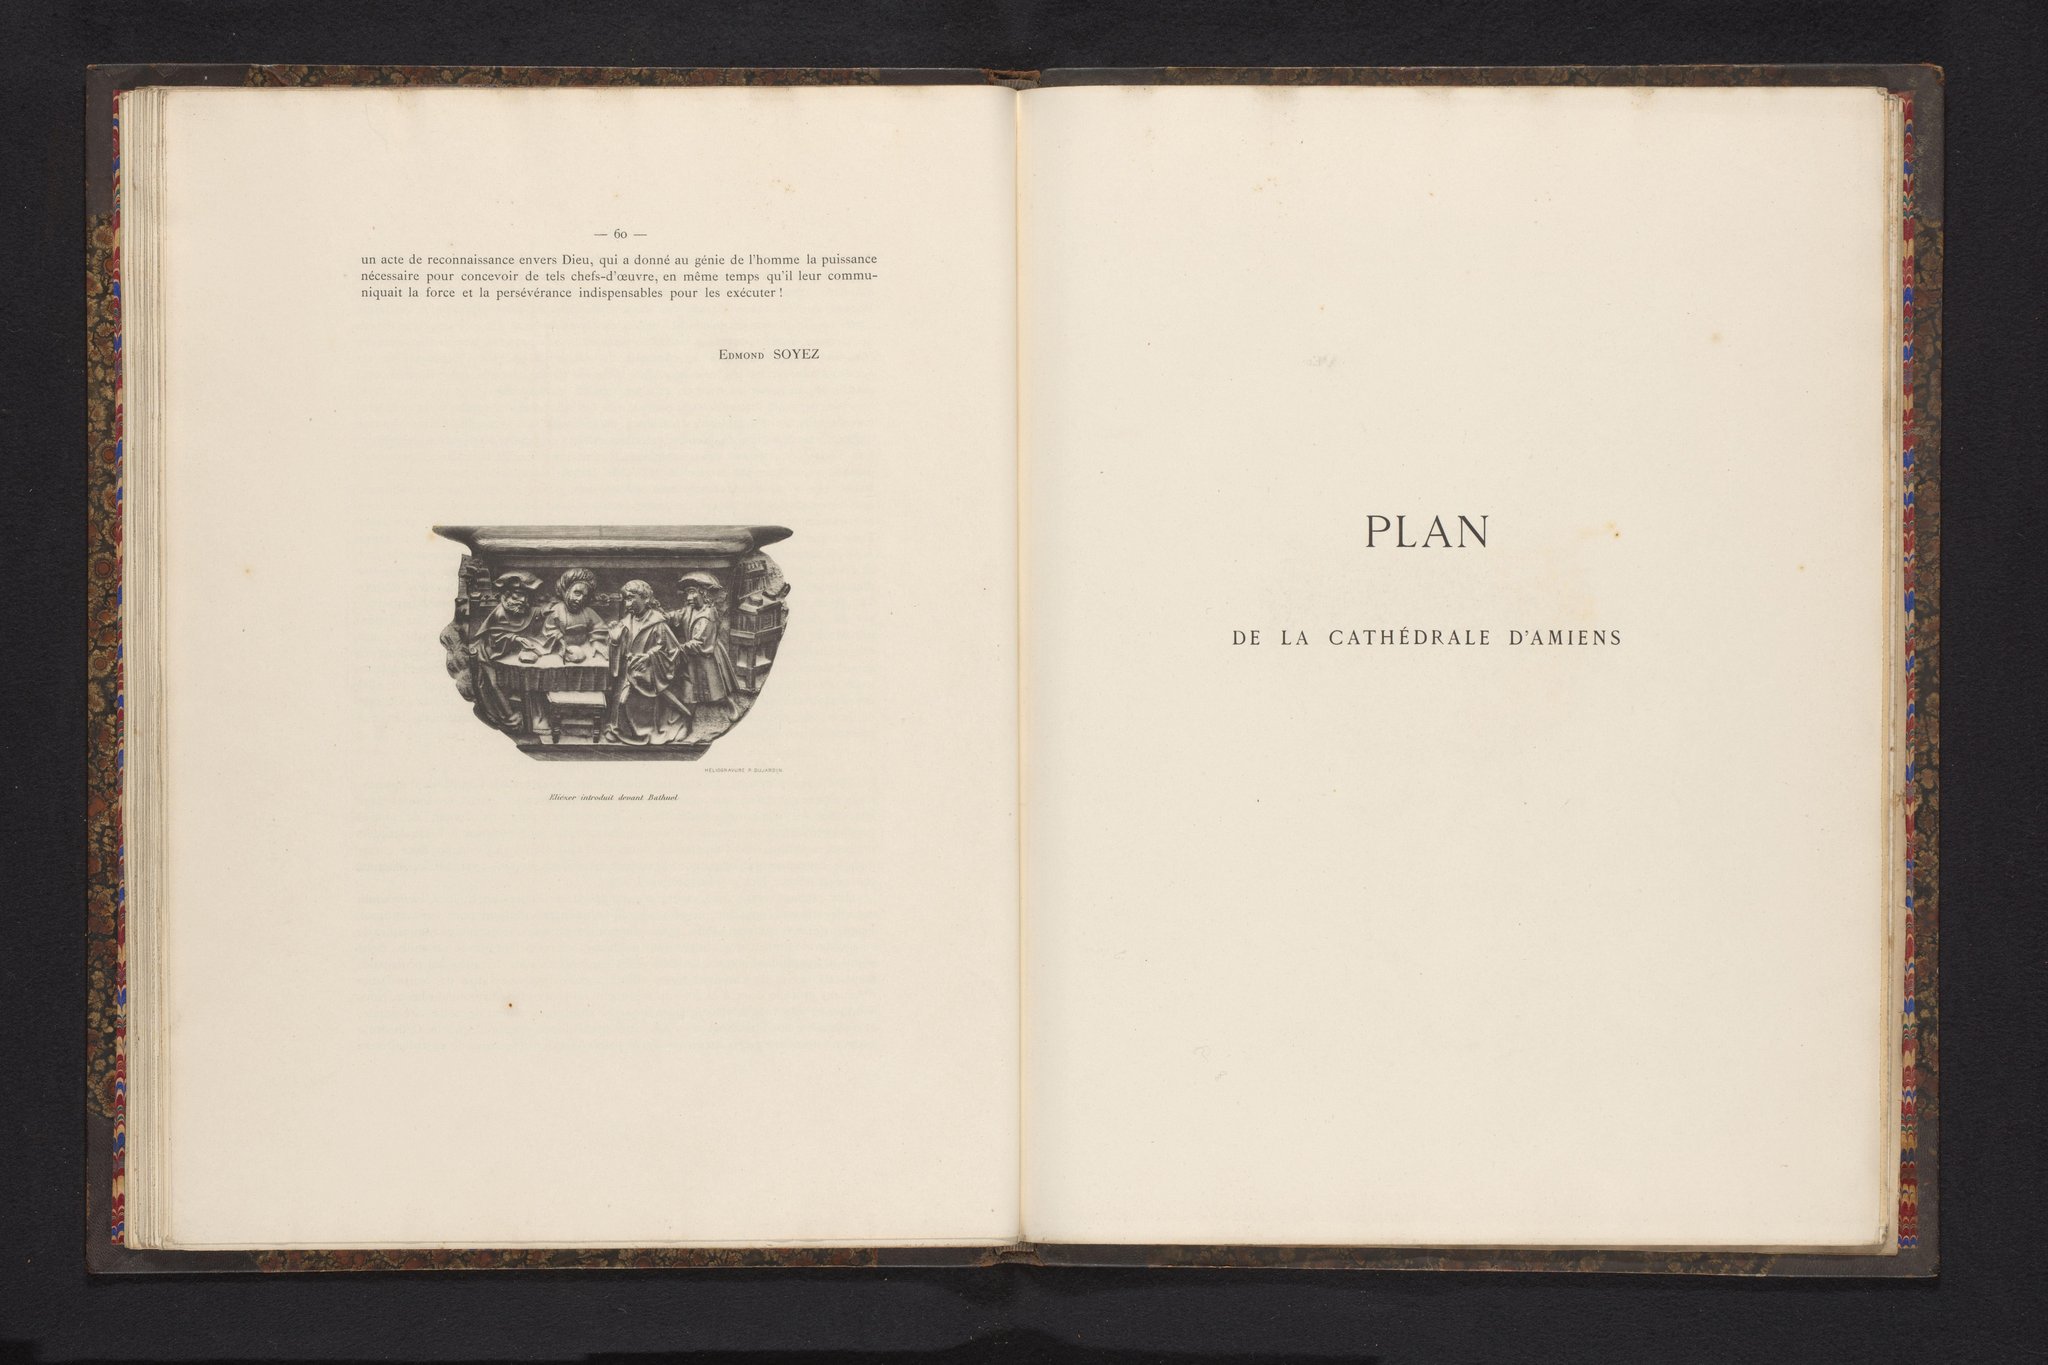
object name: photomechanical print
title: Reliëf met Bethuel in de Notre-Dame van Amiens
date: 1888-1893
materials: paper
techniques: photograph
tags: sculpture (+ relief ~ sculpture), notre-dame d'amiens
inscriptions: inscription: ‘Eliéxer introduit devant Bathuel’